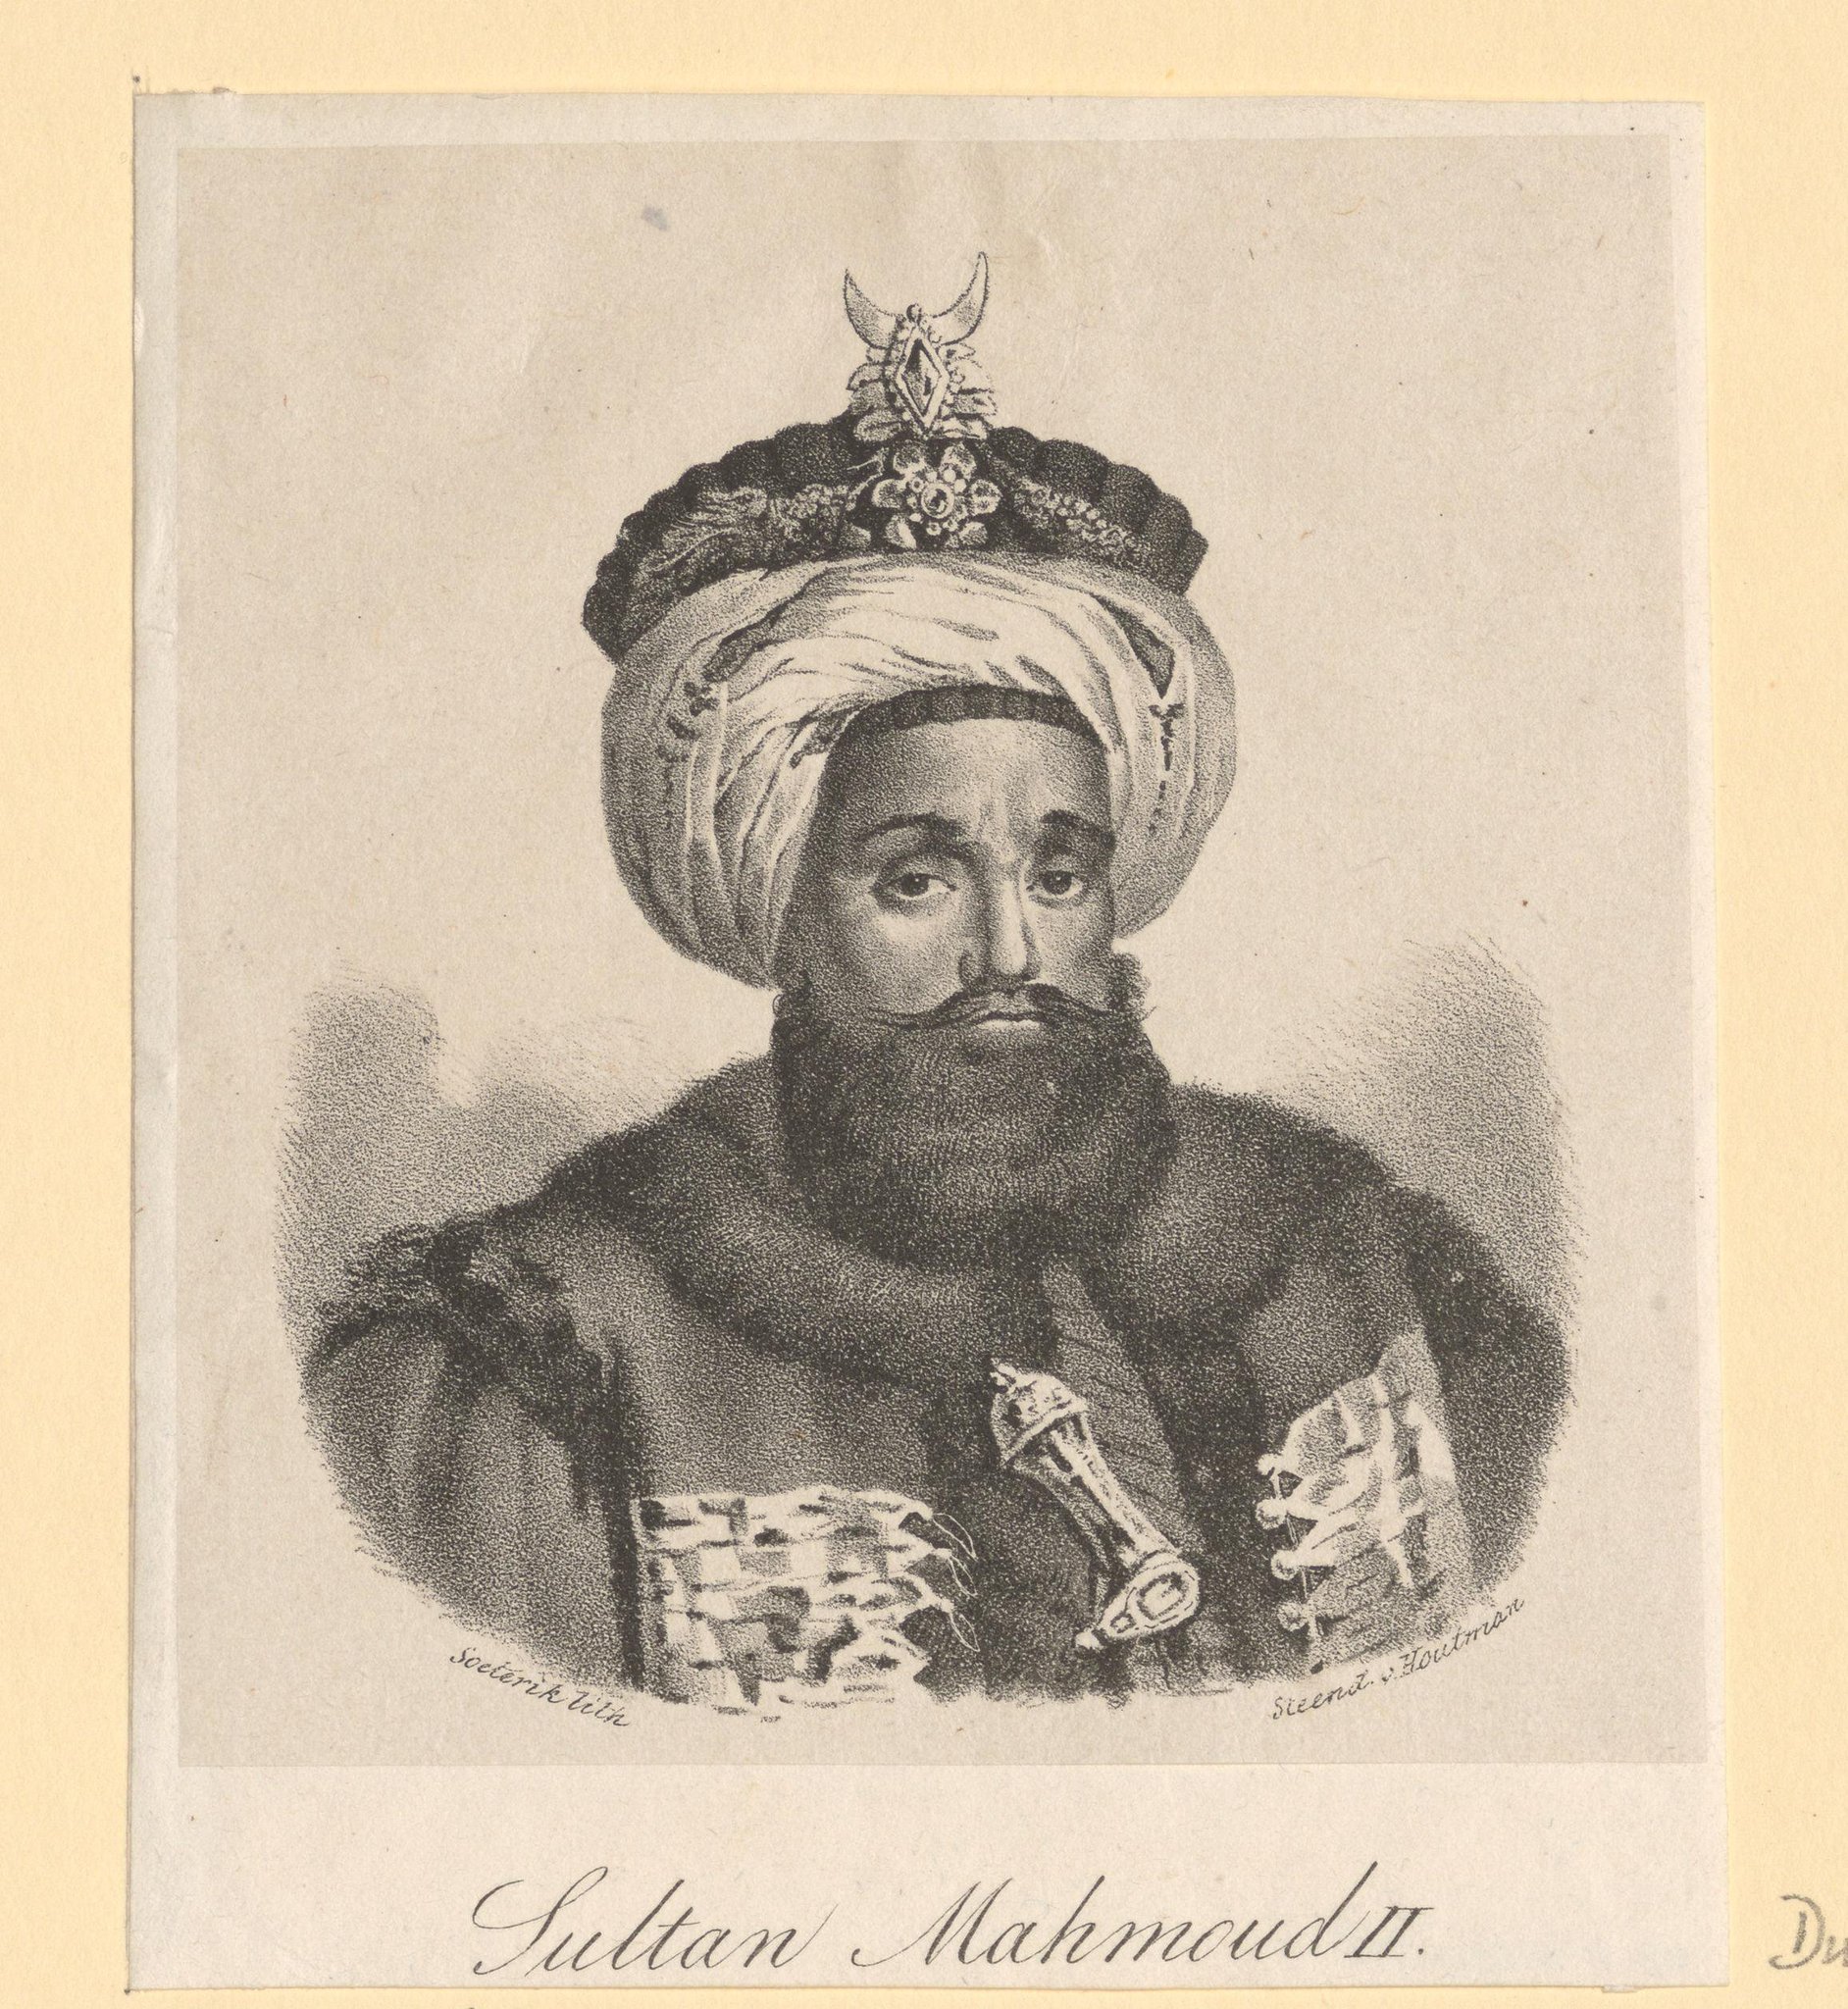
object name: print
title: Portret van Mahmut II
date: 1828-1843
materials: paper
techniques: lithograph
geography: utrecht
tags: historical persons, head-gear: turban, ruler, sovereign